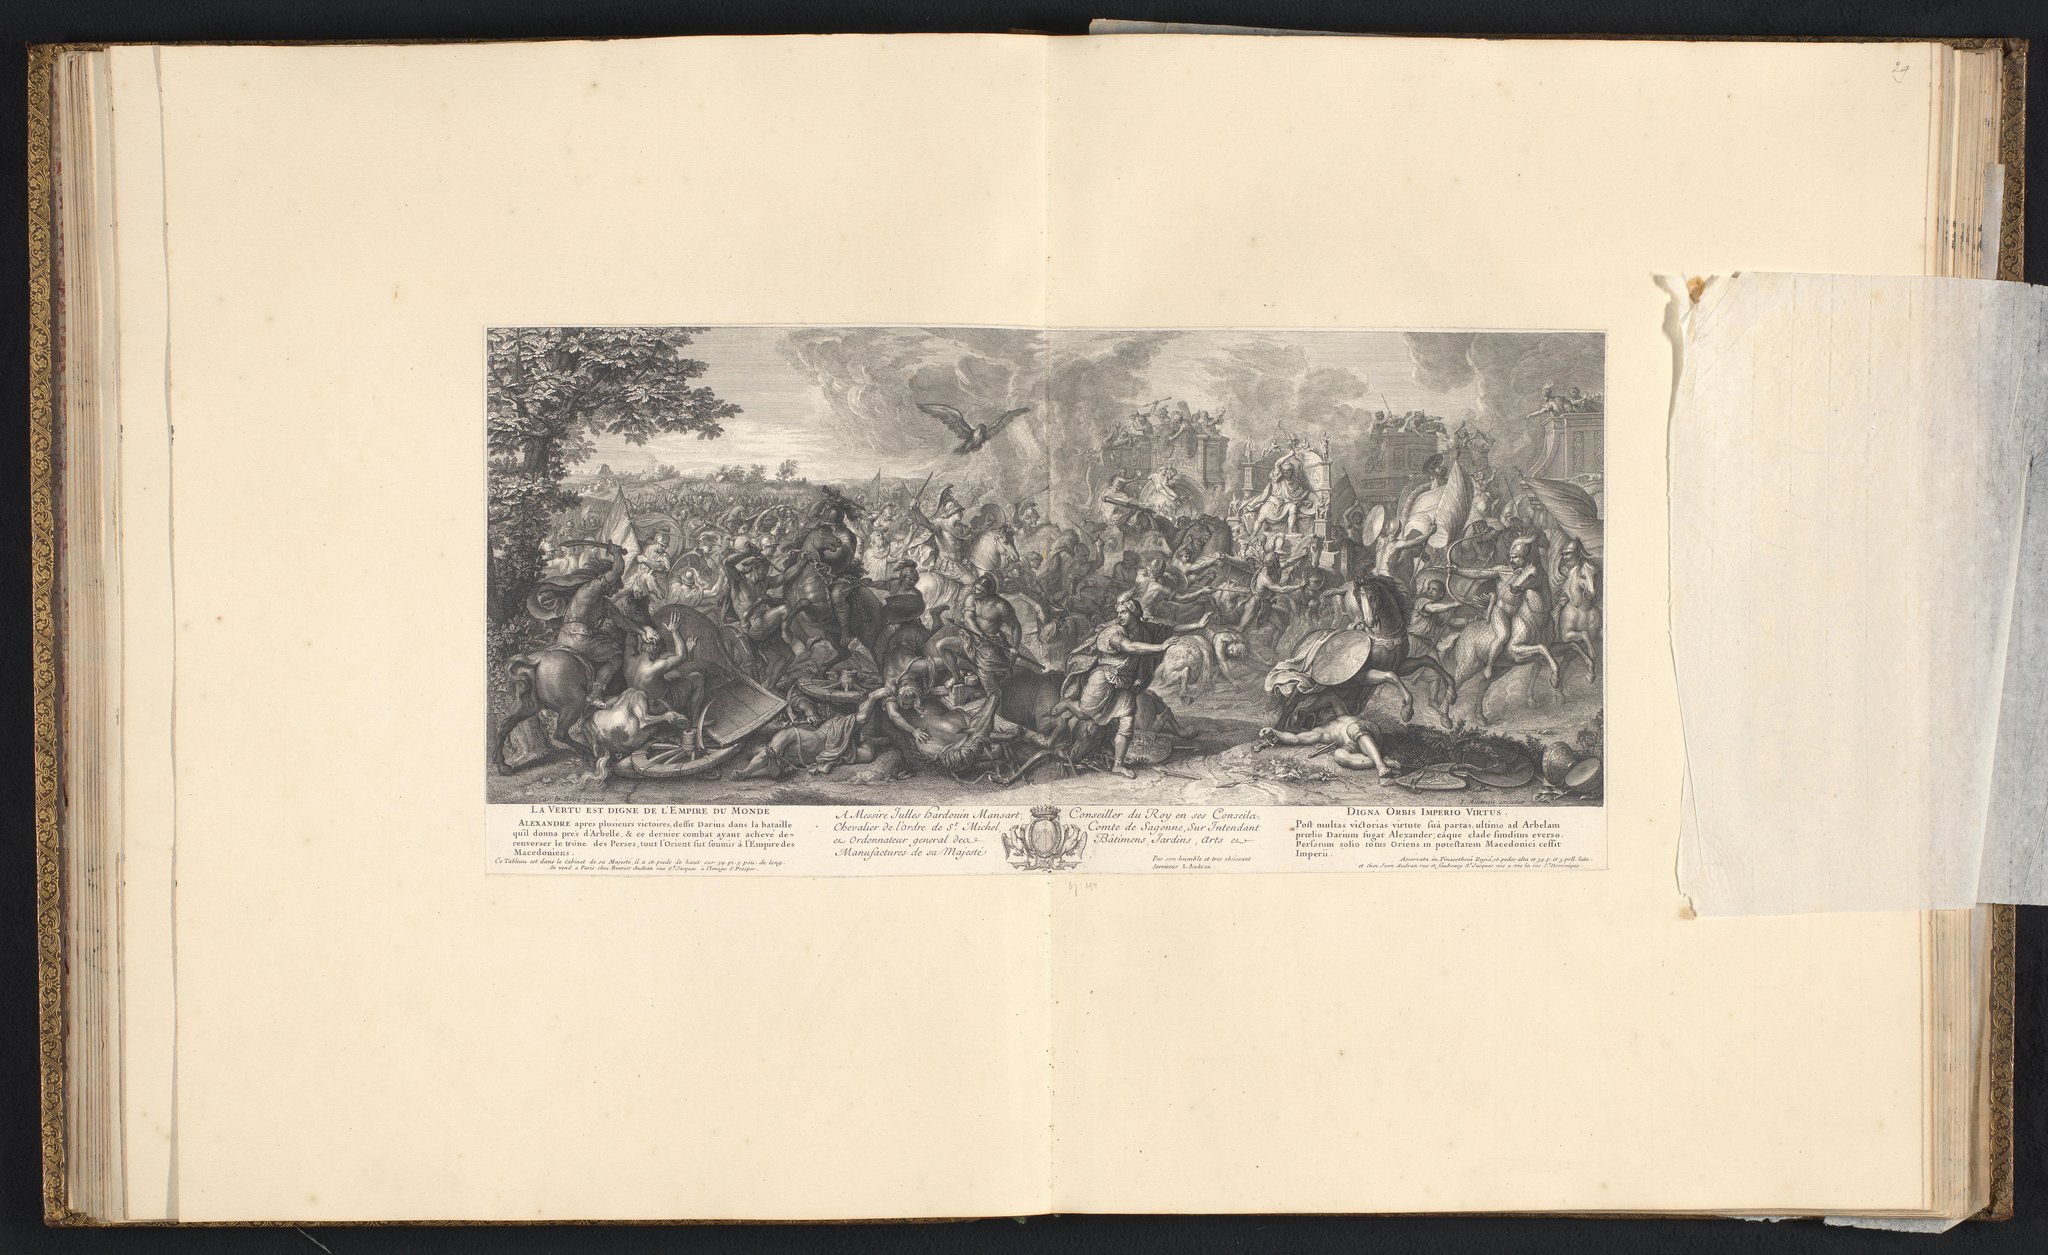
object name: album leaf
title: Les batailles d'Alexandre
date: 1677-1756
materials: paper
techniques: engraving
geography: paris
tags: battles of alexander, battle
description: Deze prent maakt deel uit van een album.